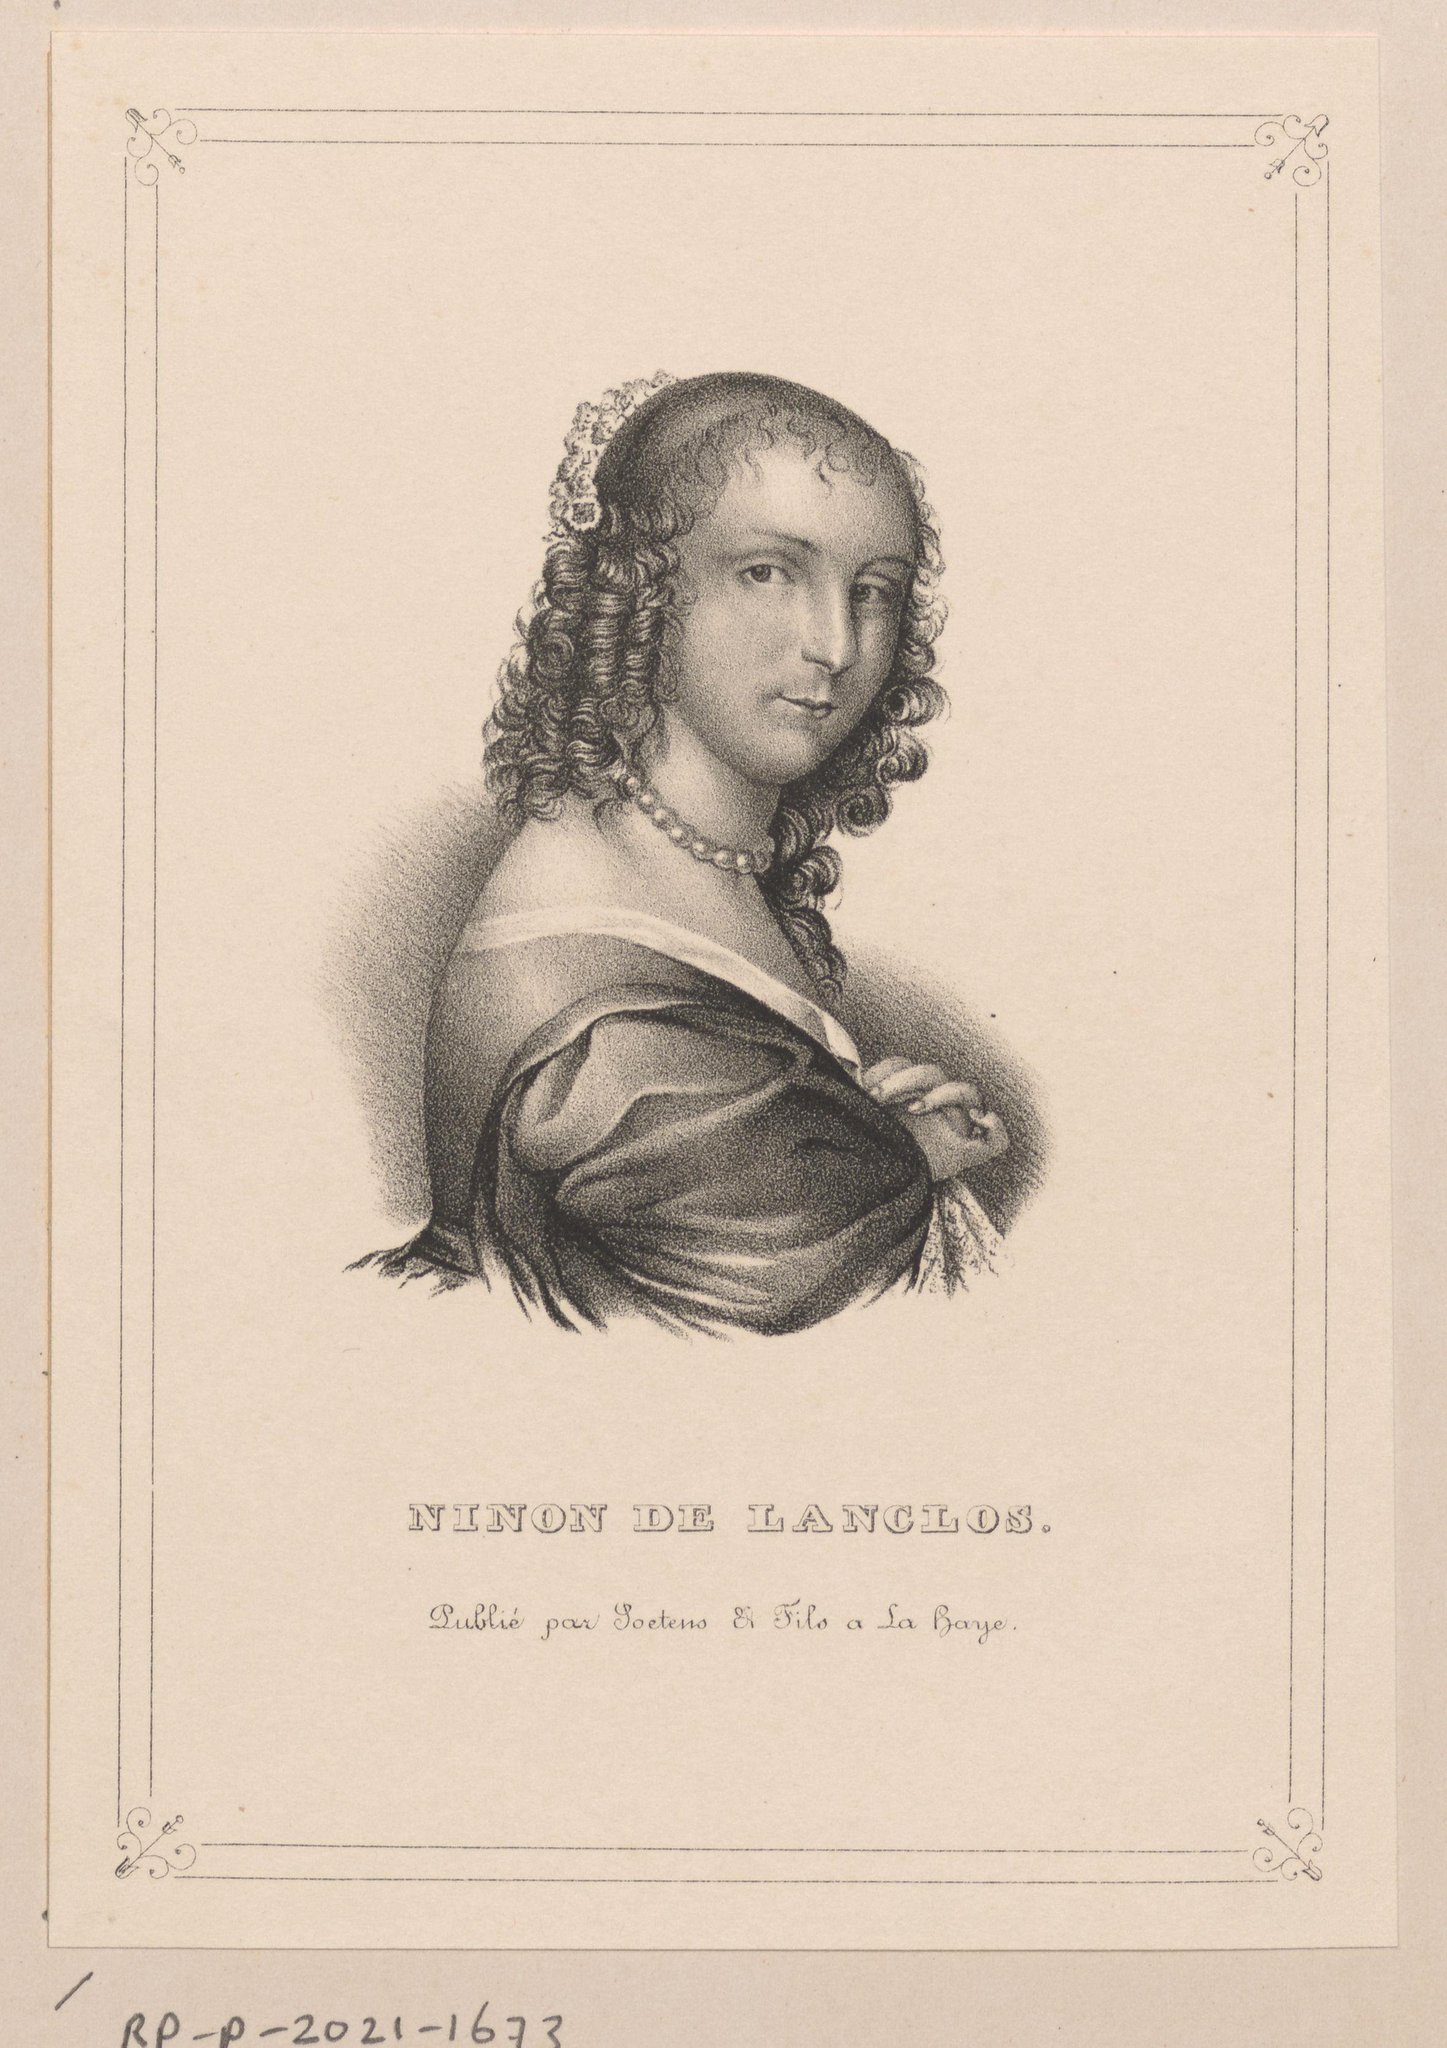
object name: print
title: Serie portretten door Soetens & Fils omstreeks 1838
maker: Anonymous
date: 1837-1840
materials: paper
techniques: lithograph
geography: the hague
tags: paris, historical persons - bb - woman, pearl; pearl necklace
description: Deze prent maakte vermoedelijk deel uit van een serie uitgegeven door Soetens & Fils omstreeks 1838, opgedragen aan de Prins van Oranje. In de 'Prospectus en Inteekenlijst' stond vermeld dat het zal bestaan uit een onbepaald aantal portretten, waarvan er drie of vier per maand verschijnen. Zie Van Someren.